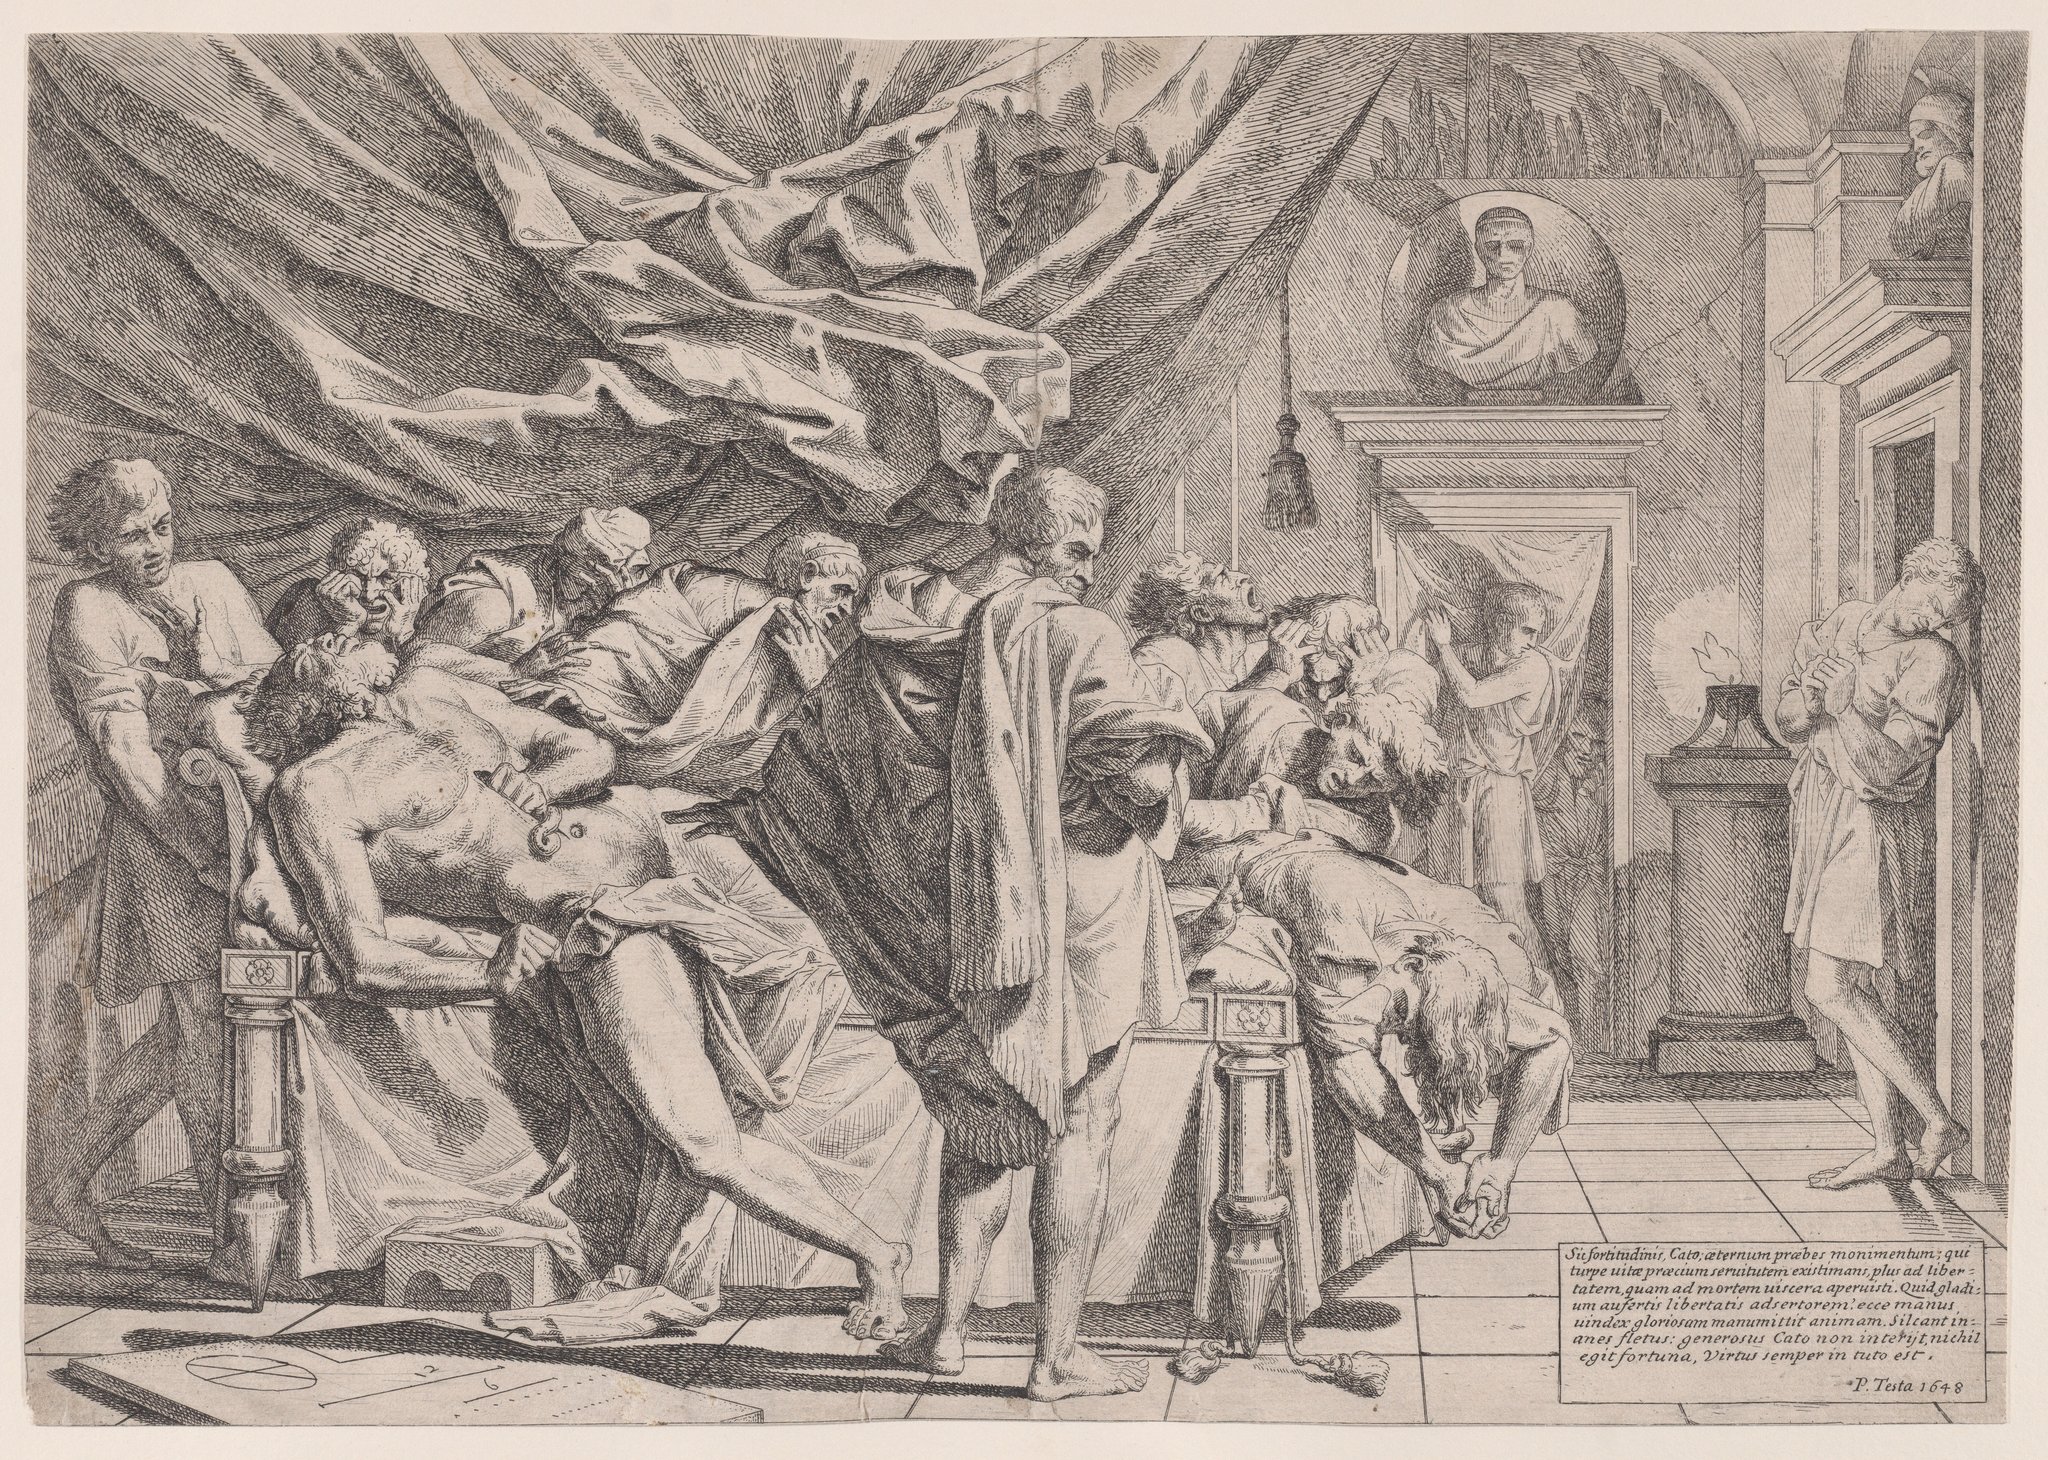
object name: print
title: The suicide of the philosopher Cato, who lies on his bed pulling out his innards watched by horrified disciples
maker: pietro testa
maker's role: artist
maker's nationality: italian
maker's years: 1612-1650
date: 1648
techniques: etching